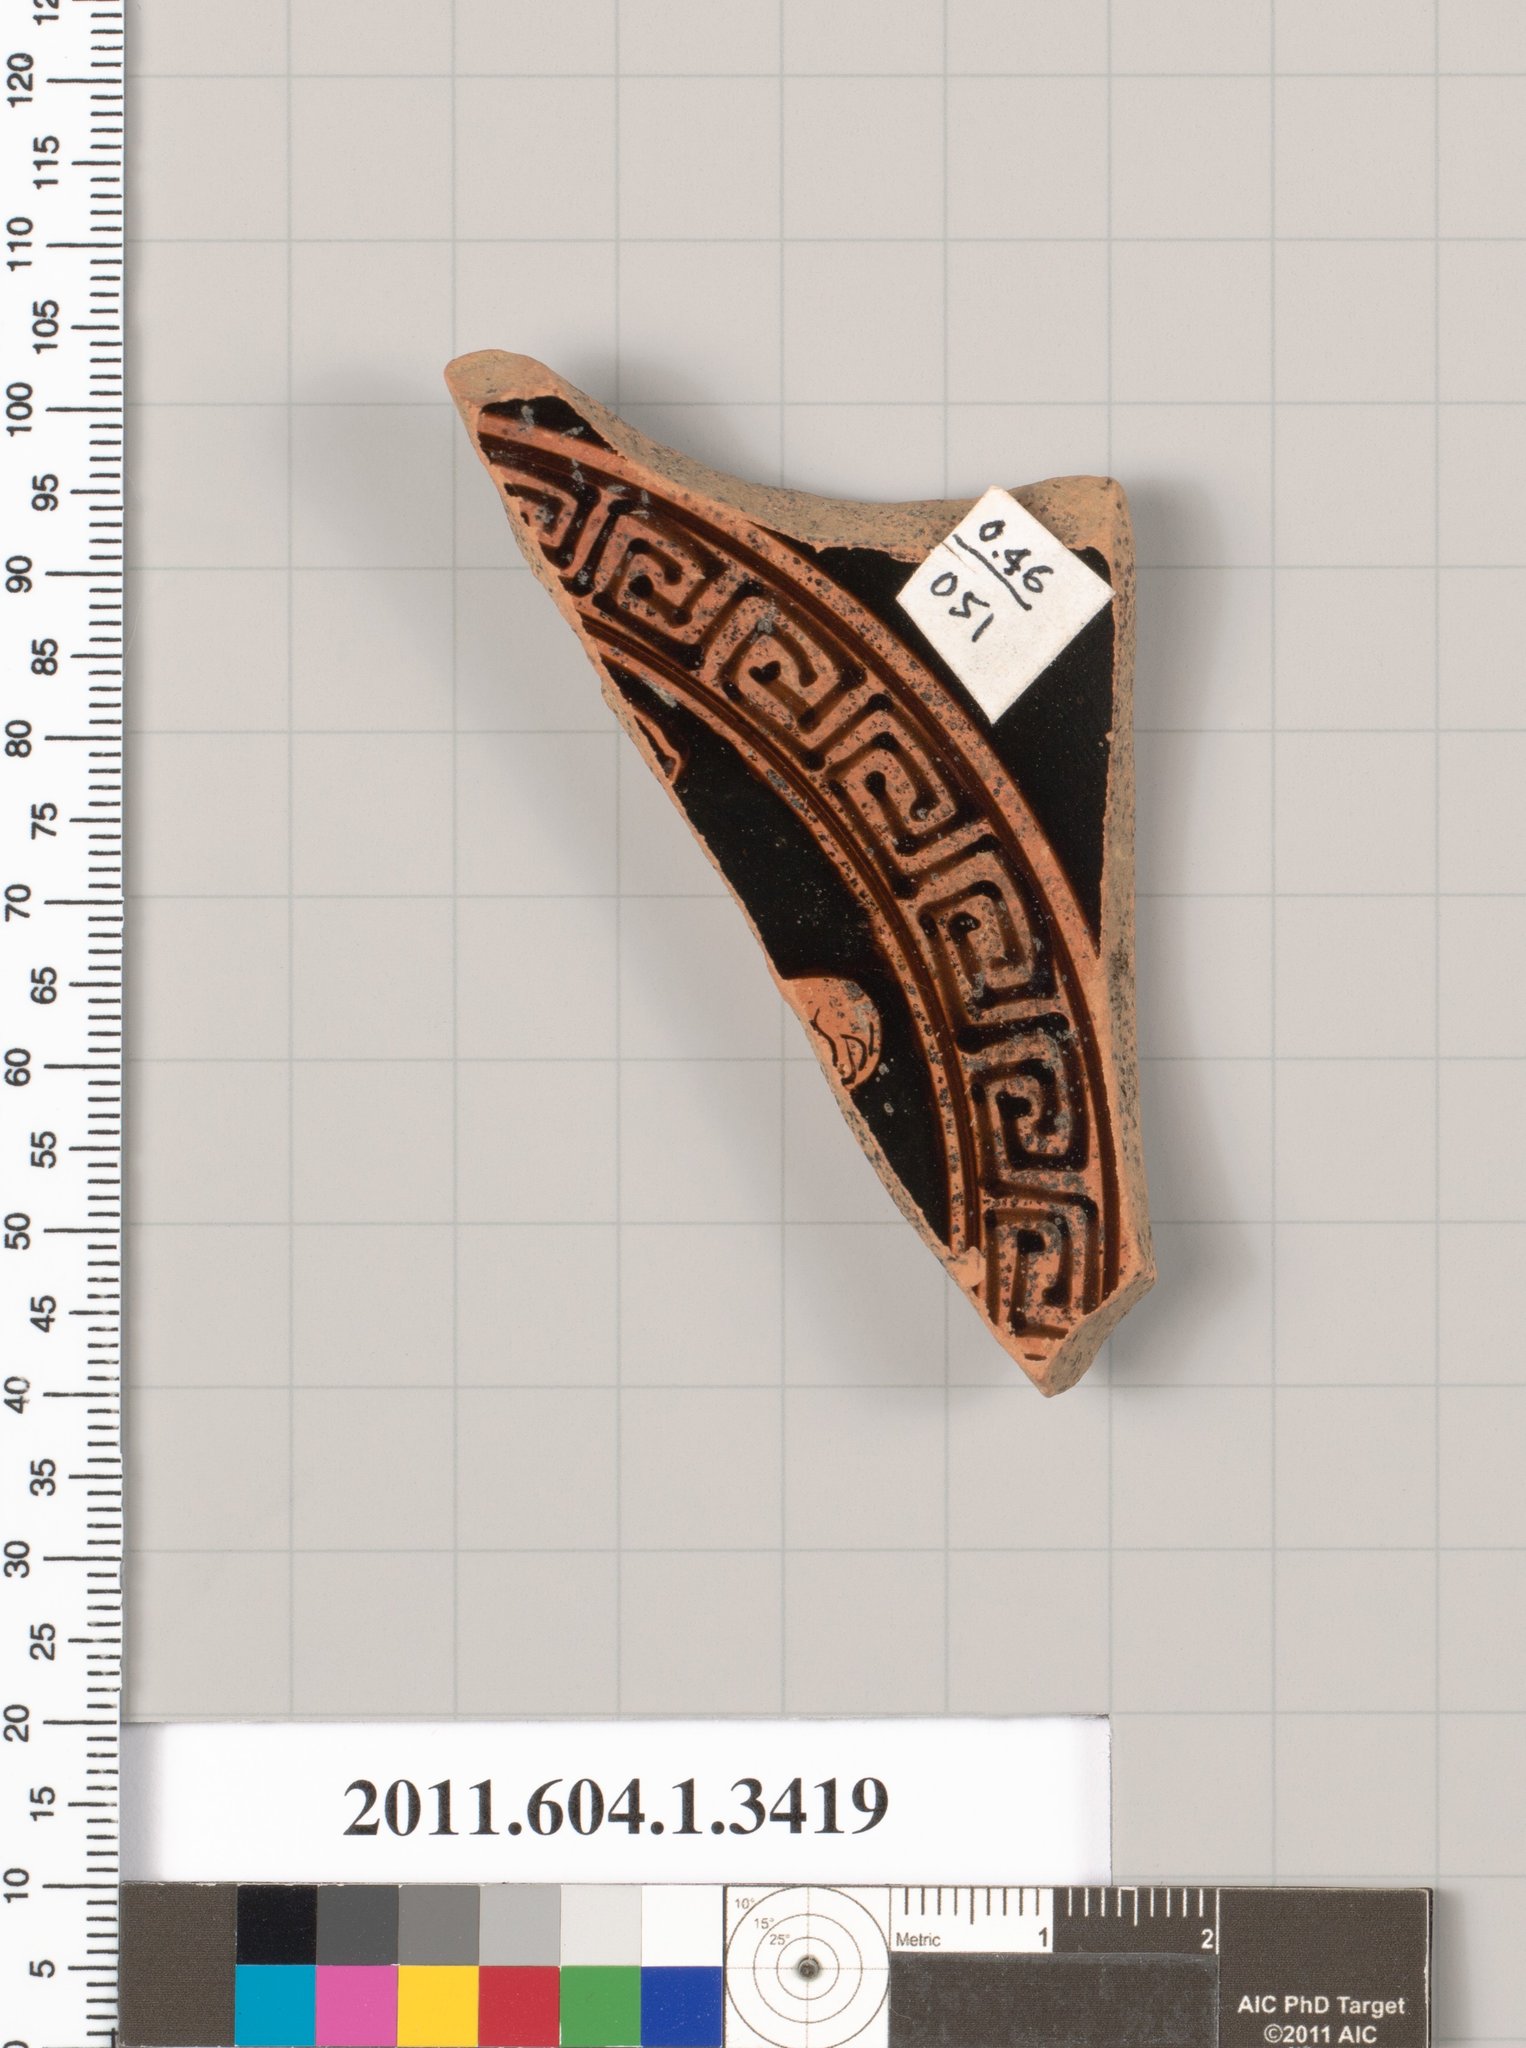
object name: kylix fragment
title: Terracotta fragment of a kylix (drinking cup)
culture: greek, attic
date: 475-451 BCE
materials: terracotta